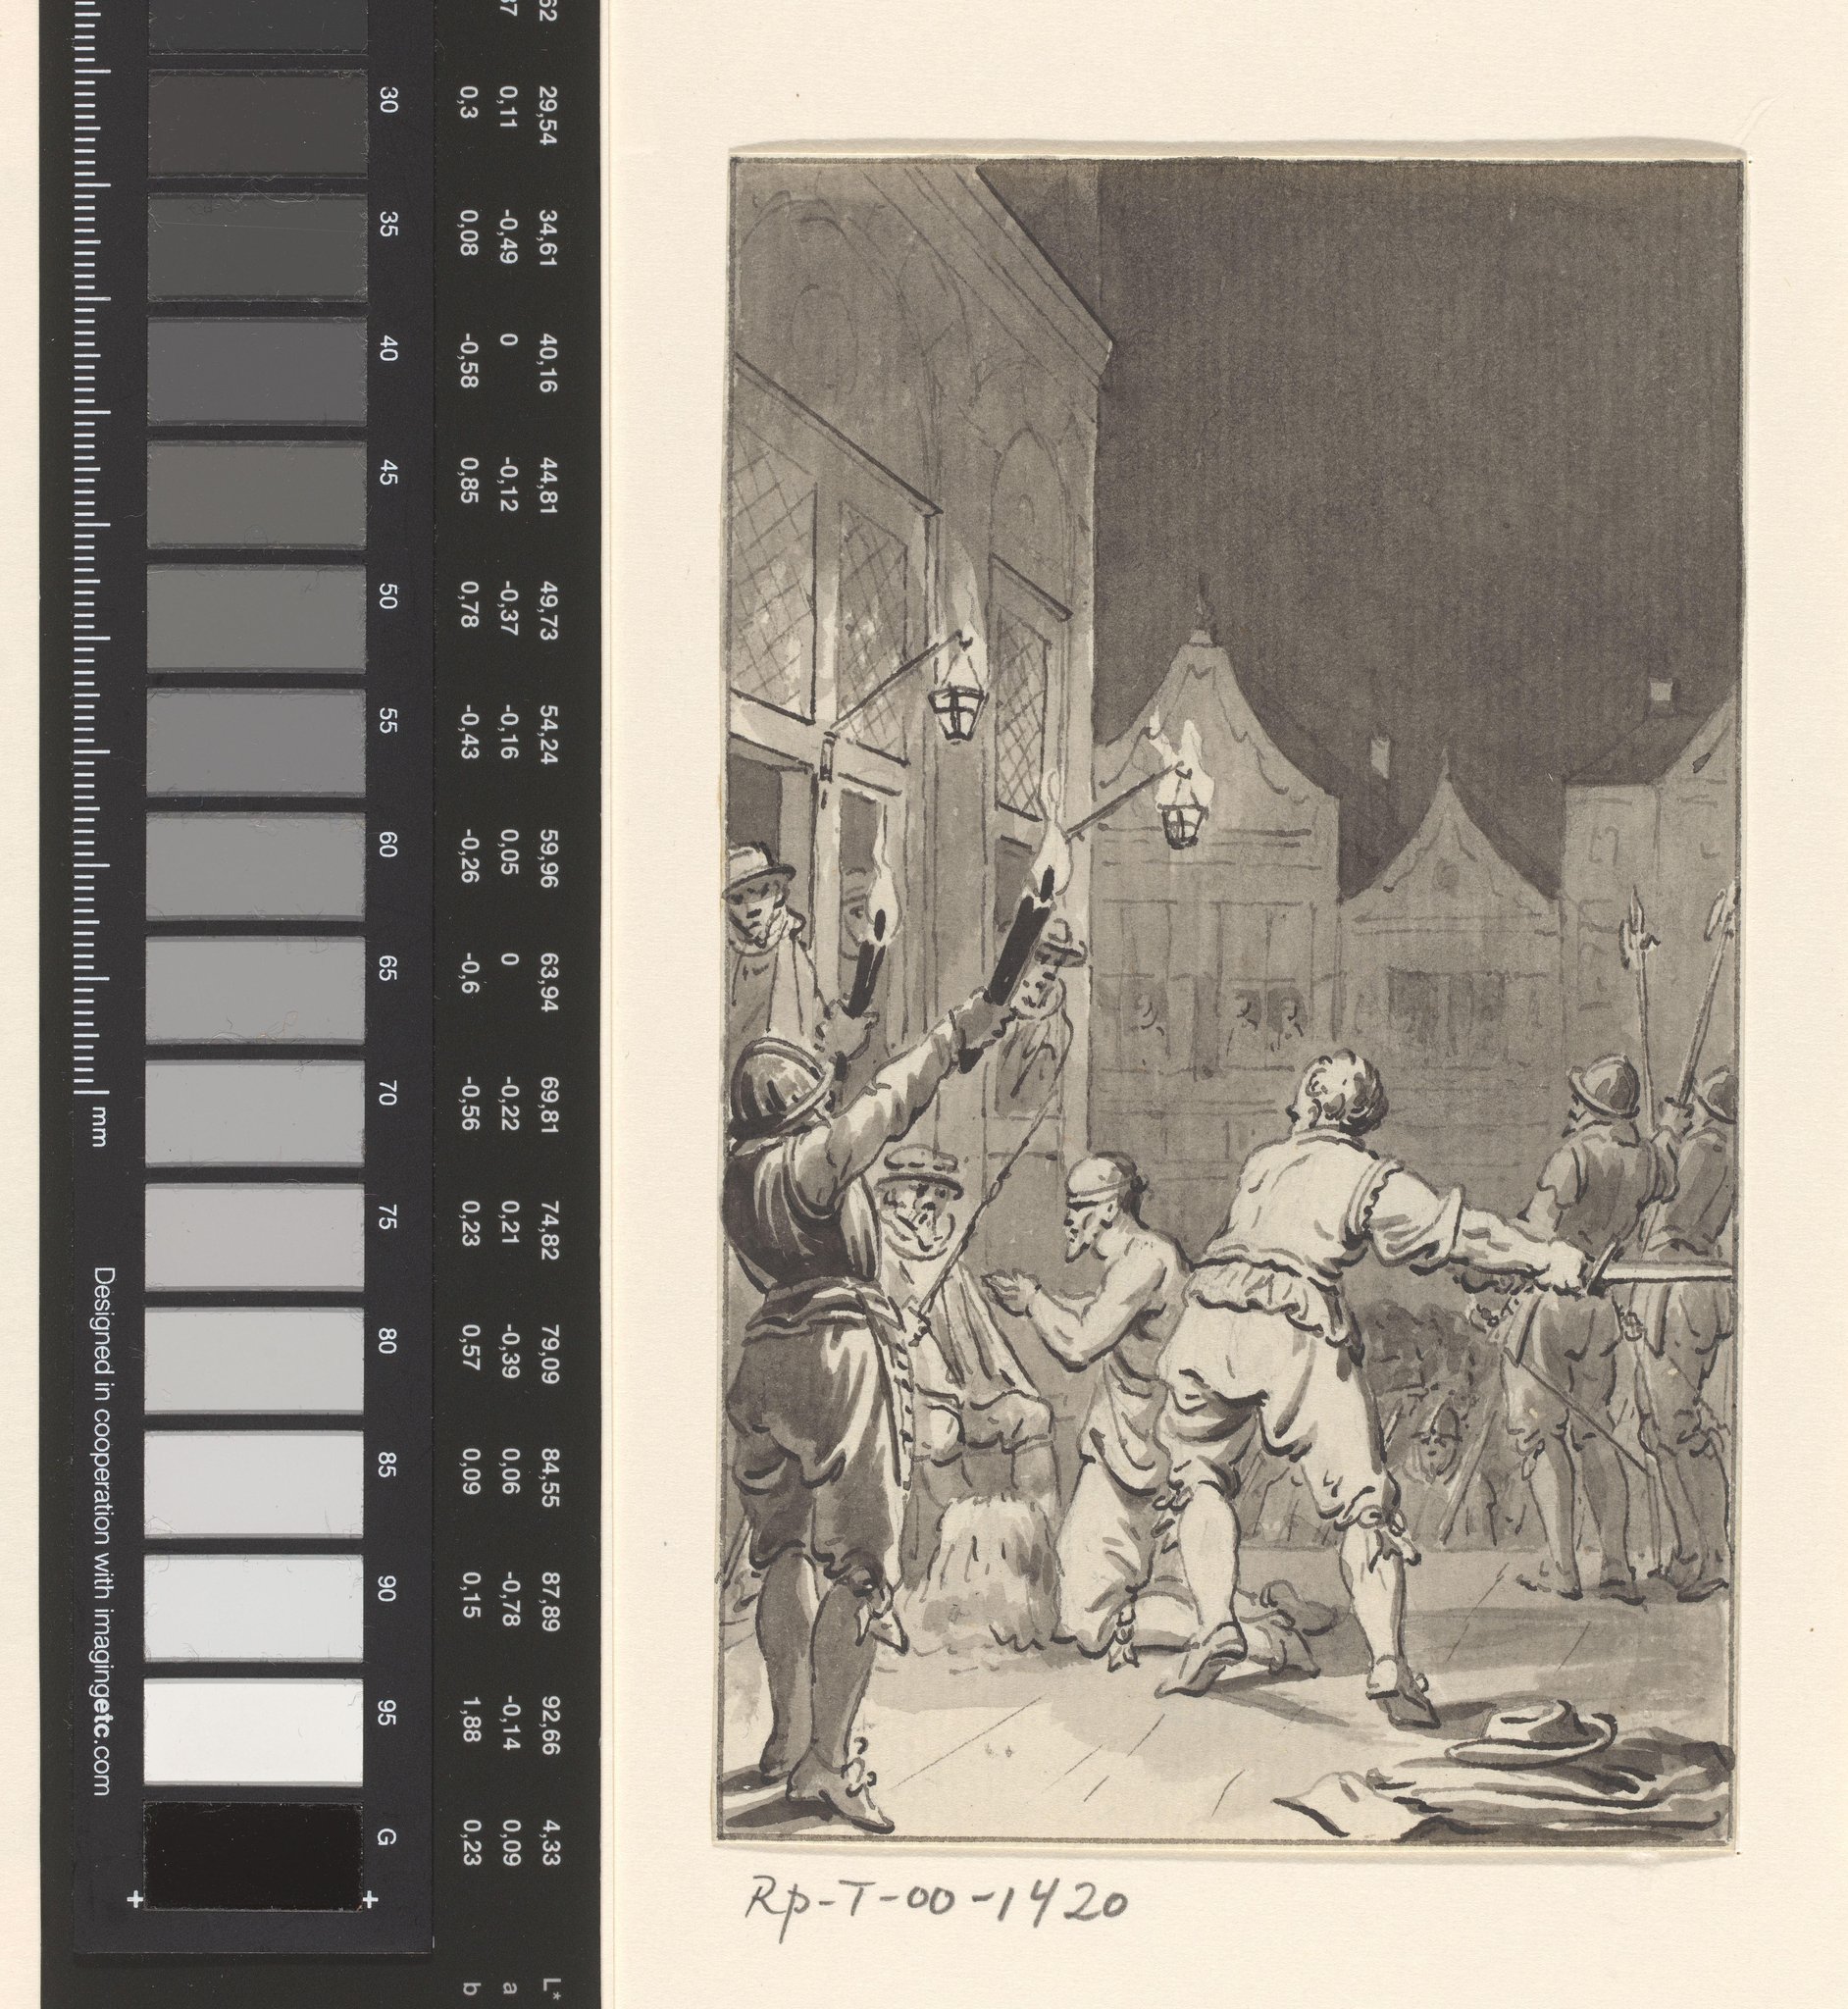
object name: history print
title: Onthoofding van Nicolas Gosson te Atrecht, 1578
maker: jacobus buys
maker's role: draughtsman, print maker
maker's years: 1724-1801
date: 1785-1787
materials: ink, paper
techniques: brush, pen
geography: netherlands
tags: historical persons, on the scaffold or place of execution, violent death by beheading, historical events and situations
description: Ontwerptekening voor illustratie in: Jacobus Kok, Vaderlandsch Woordenboek, Johannes Allart, Amsterdam 1785-1799, 35 delen, dl. XVIII, pl. IV. Niet in Frederik Muller; door het RPK toegevoegd nummer.